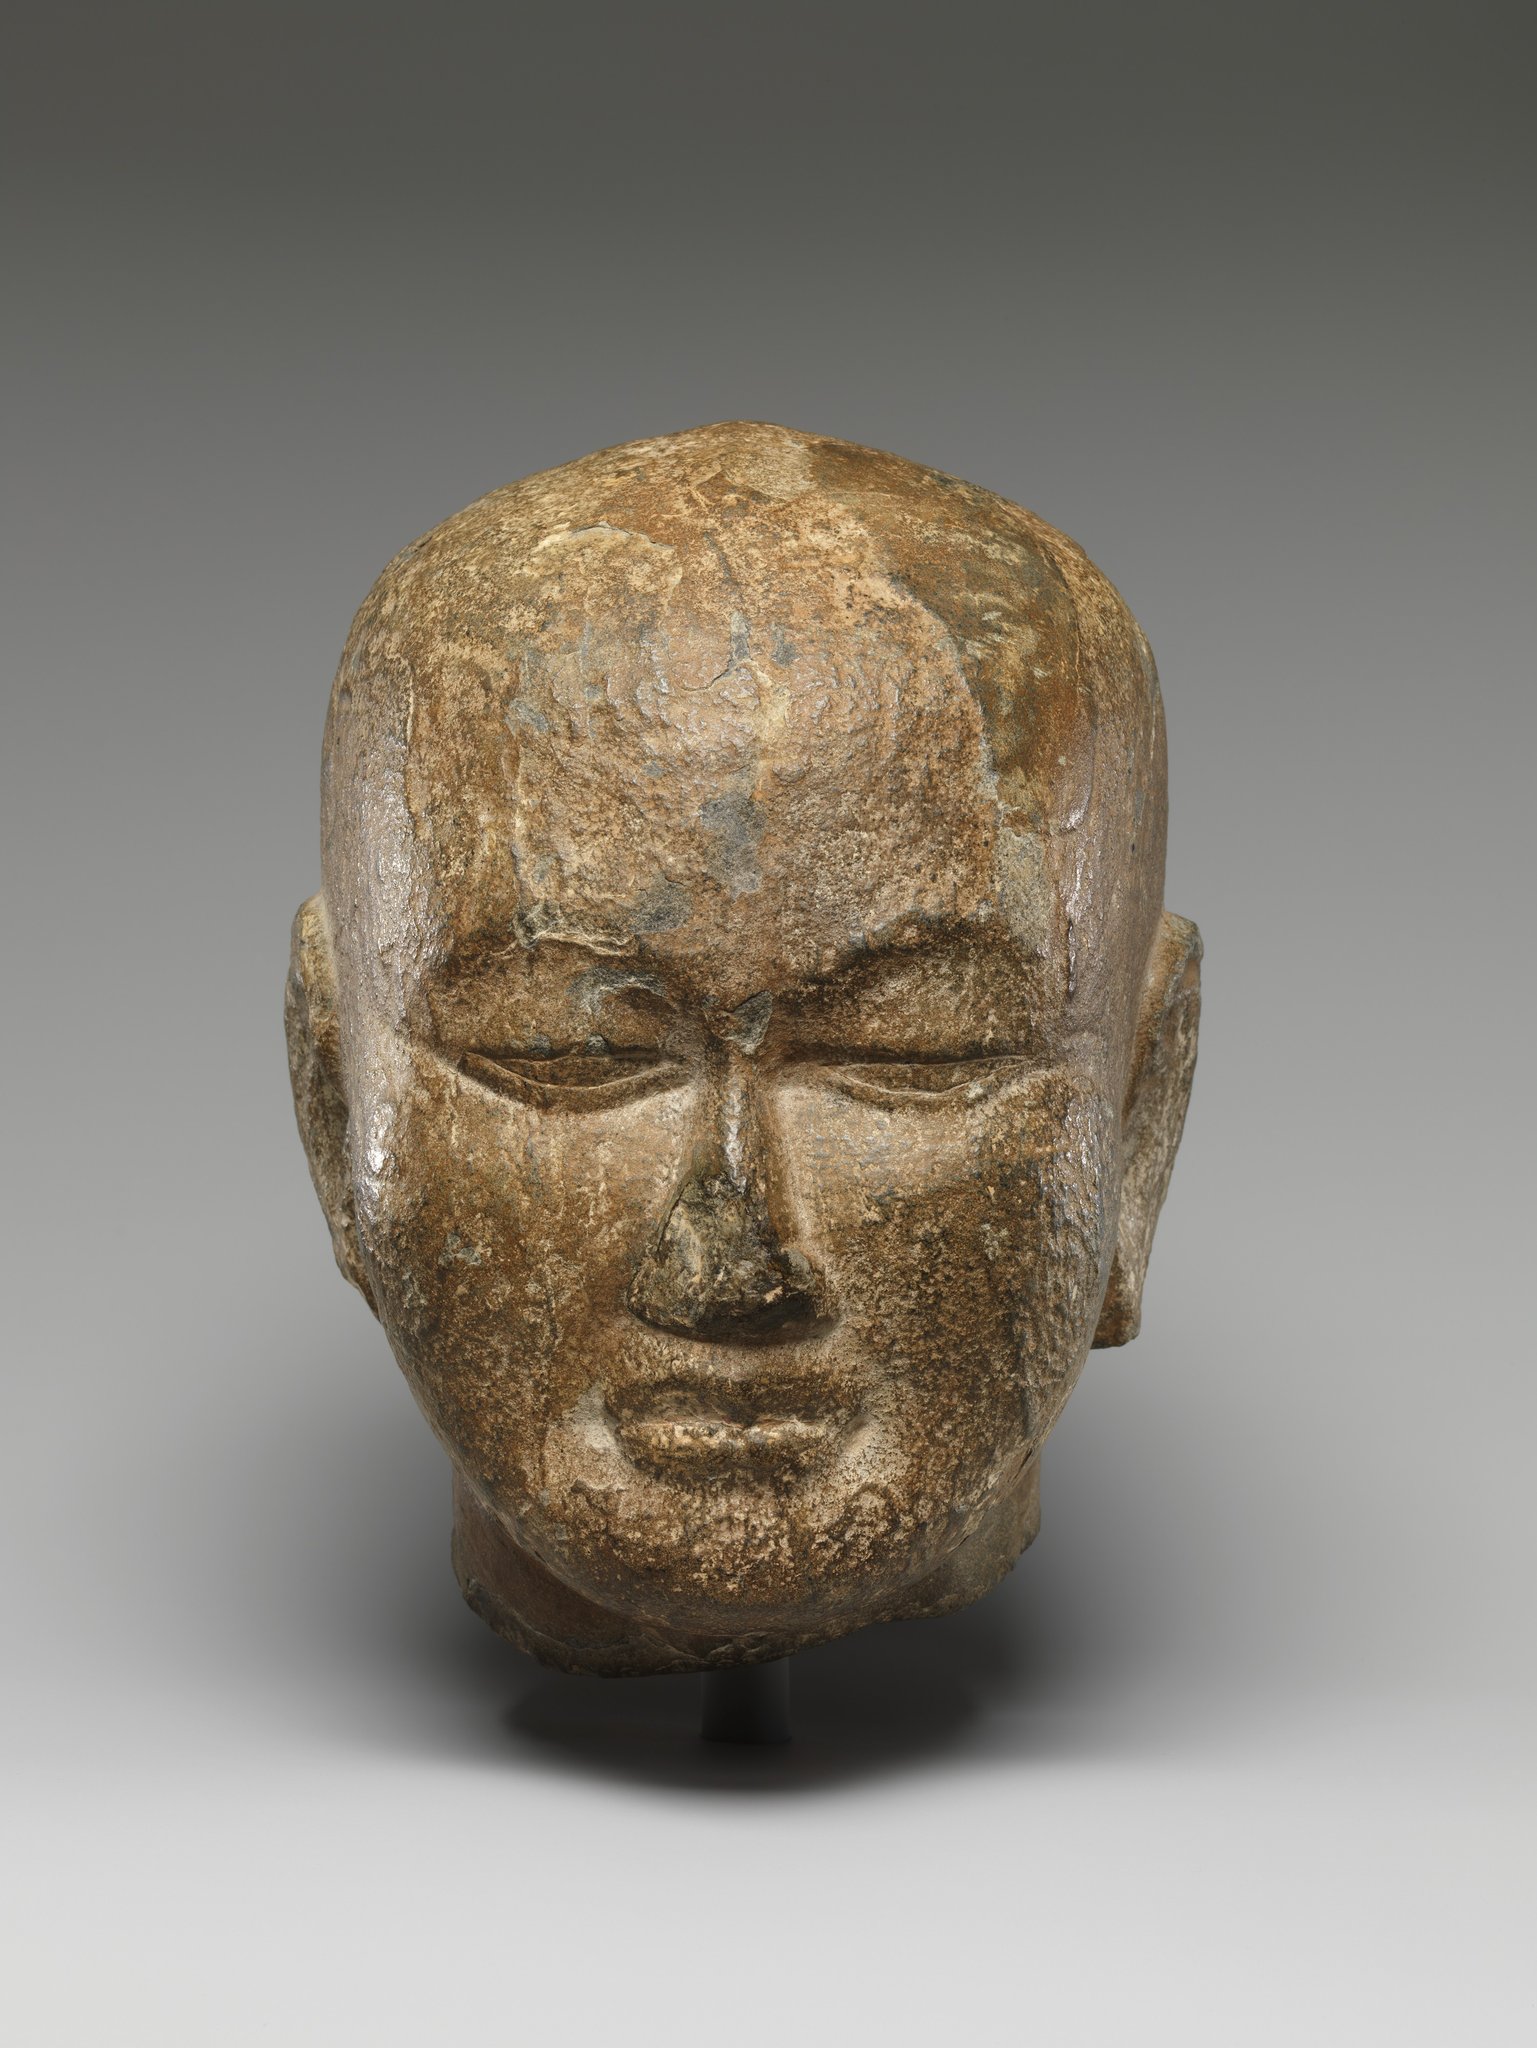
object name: head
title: Head of a Monk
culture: chinese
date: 601-700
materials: limestone